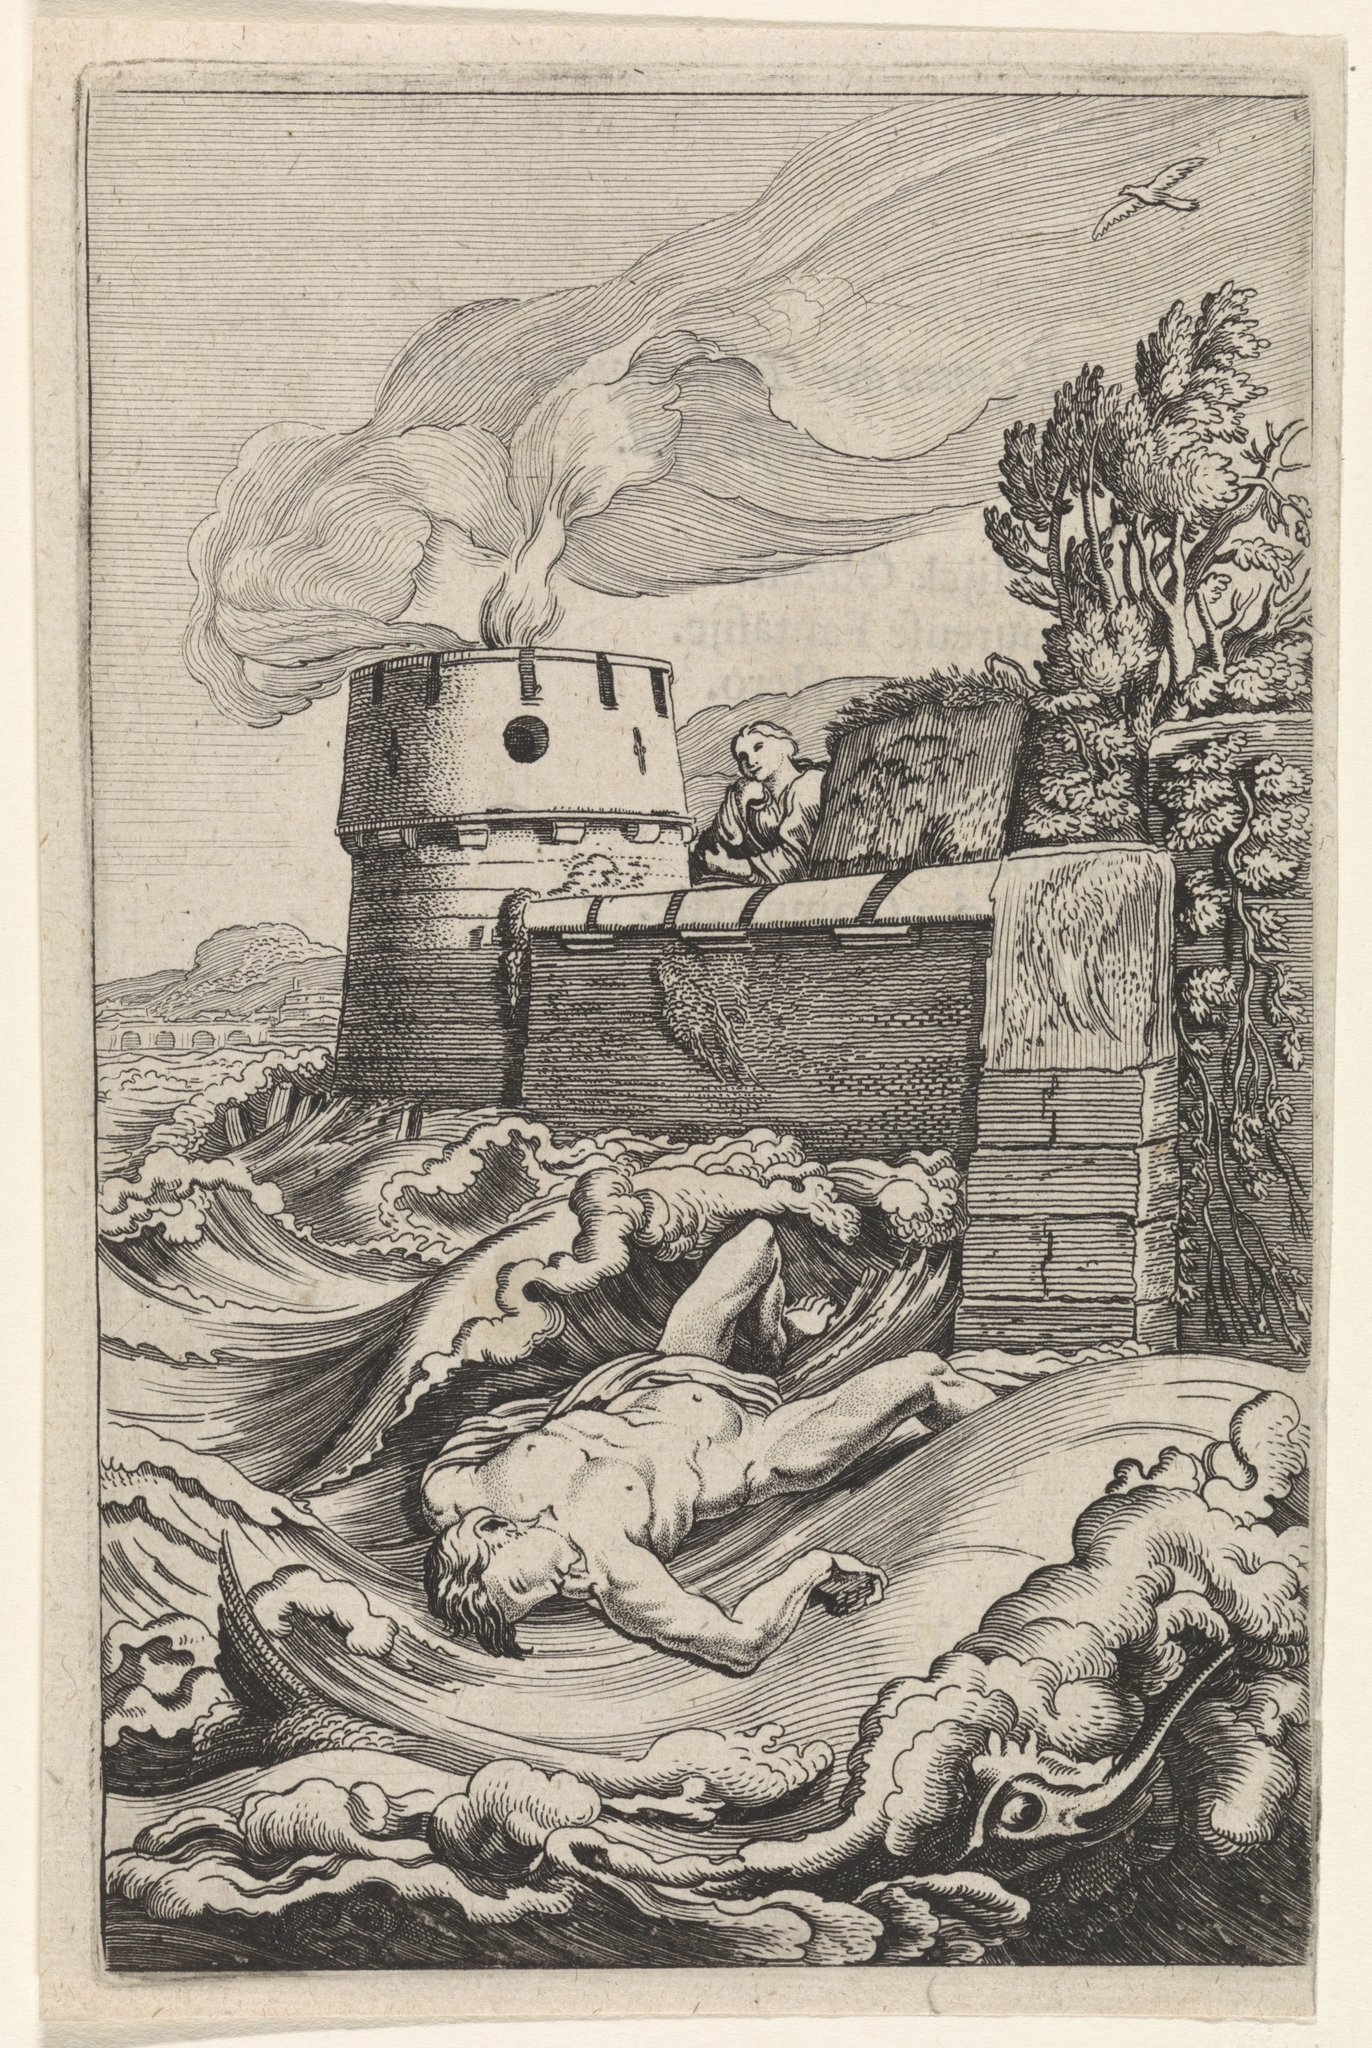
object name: print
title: Hero en Leander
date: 1621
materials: paper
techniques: etching, letterpress printing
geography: rotterdam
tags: (story of) hero and leander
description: Boekillustratie in: Houwaert, Johan Baptista. Den handel der amoureusheyt inhoudende vier poetische spelen. Rotterdam: Jan van Waesberghe III, 1621.